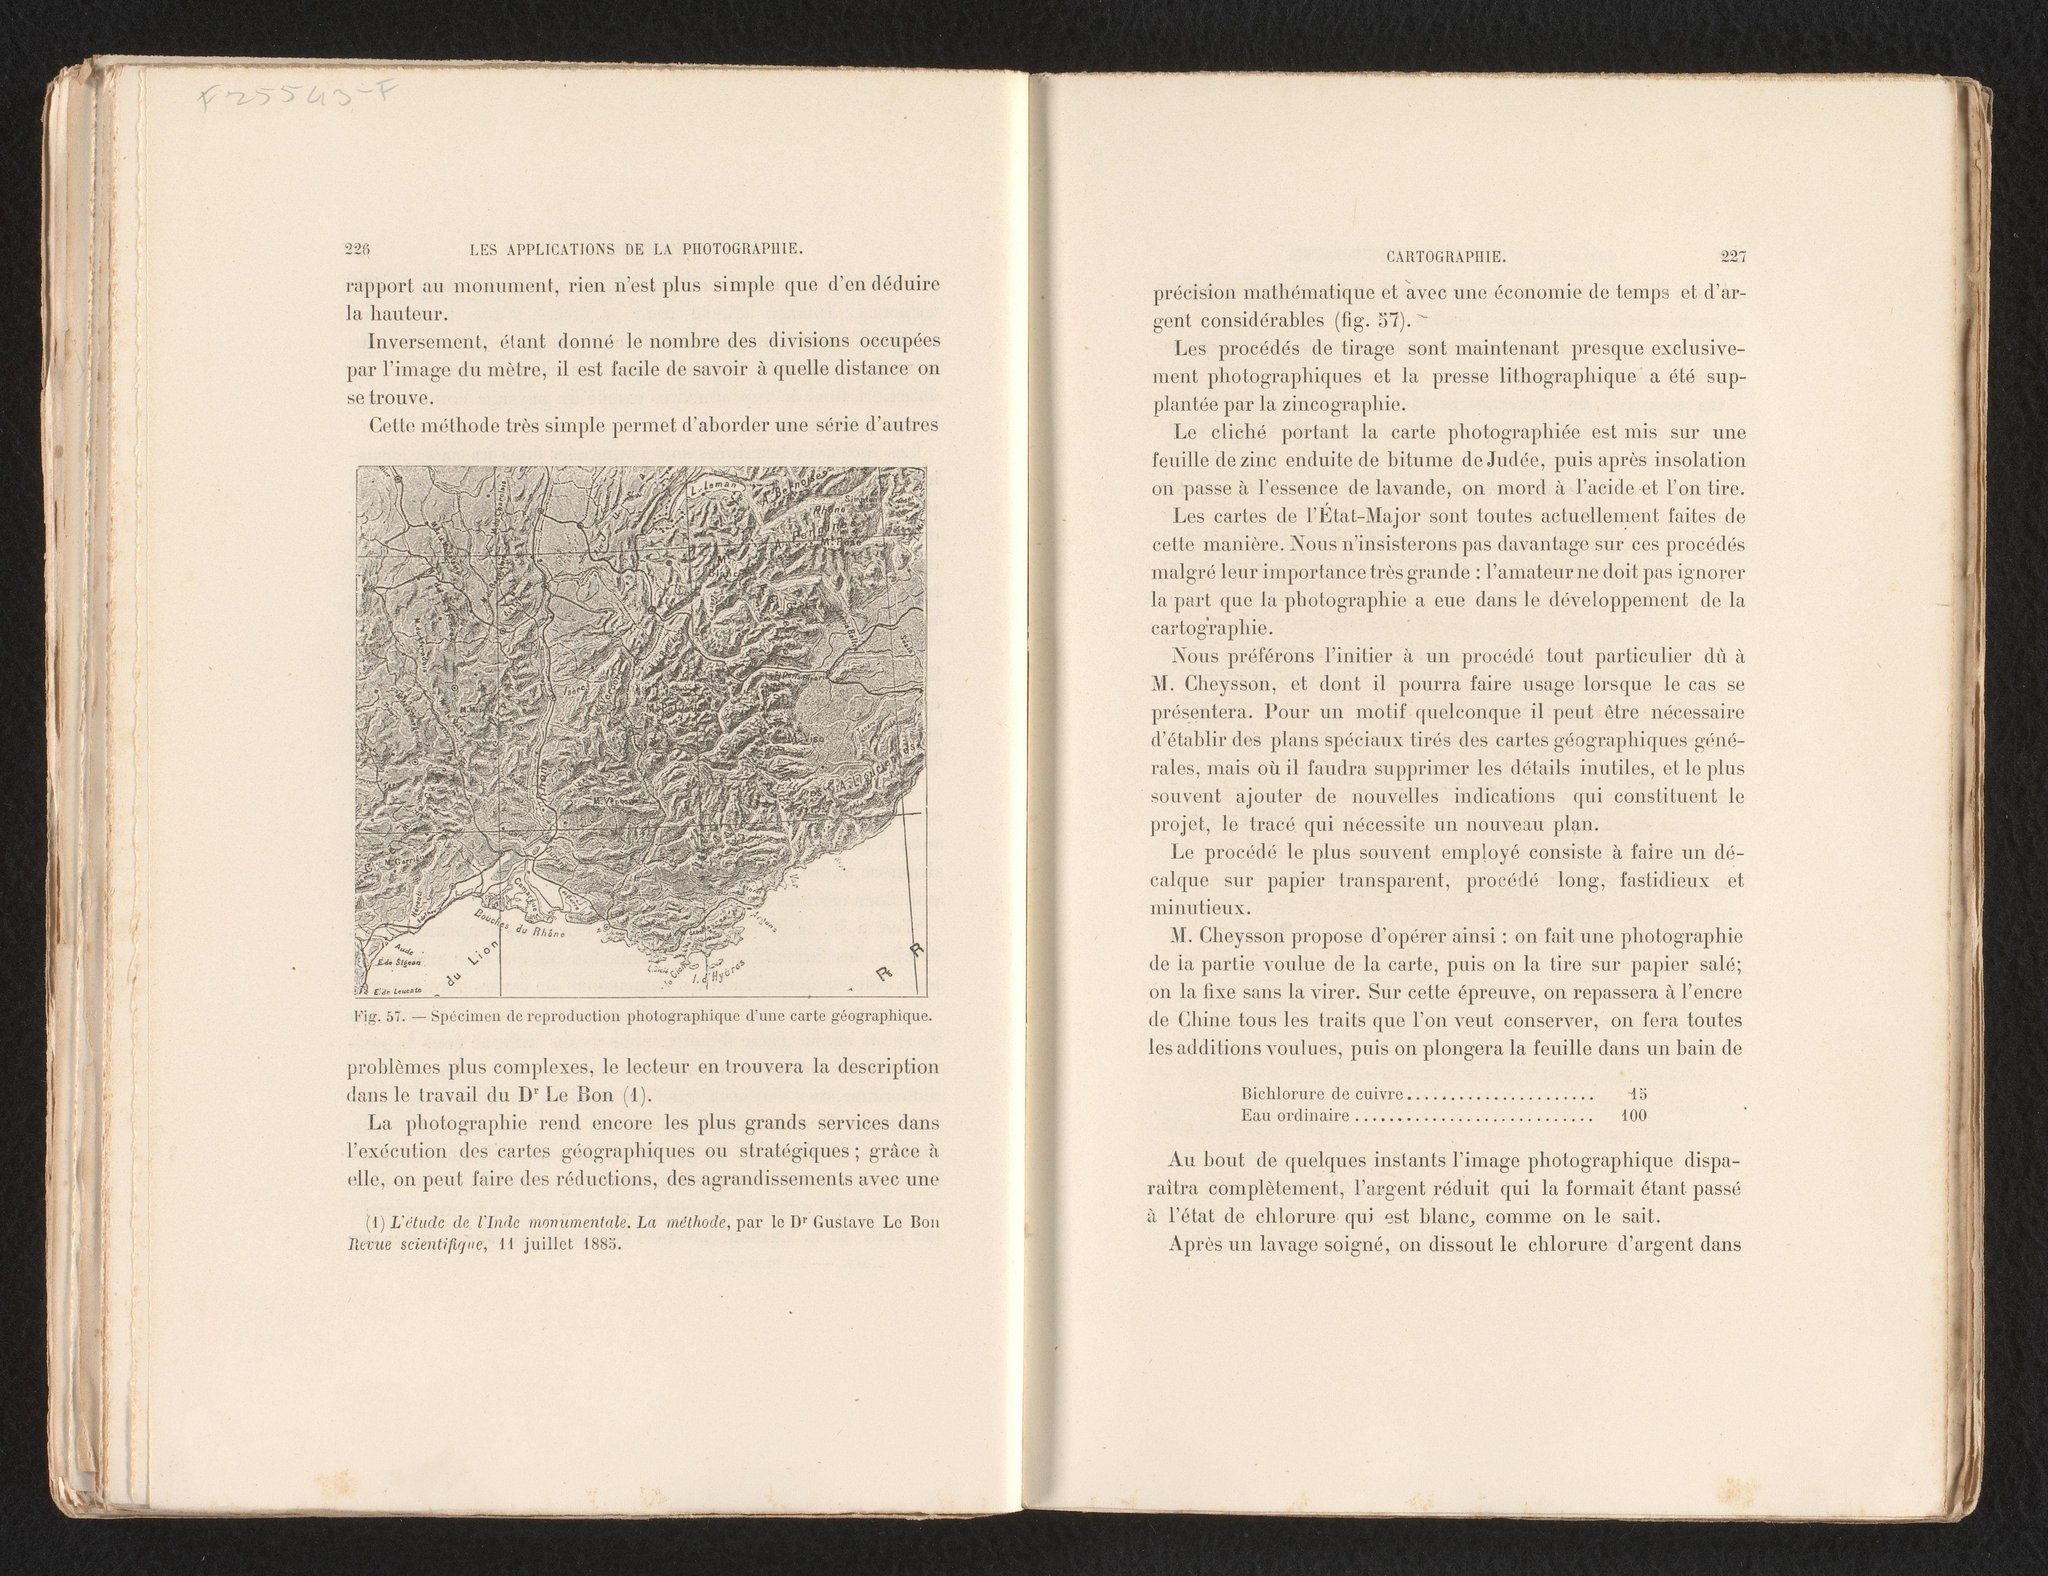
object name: photomechanical print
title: Spécimen de reproduction photographique d'une carte géographique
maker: Anonymous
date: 1883-1888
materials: paper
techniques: collo-autotype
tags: maps of separate countries or regions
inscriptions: number: ‘Fig. 57.’